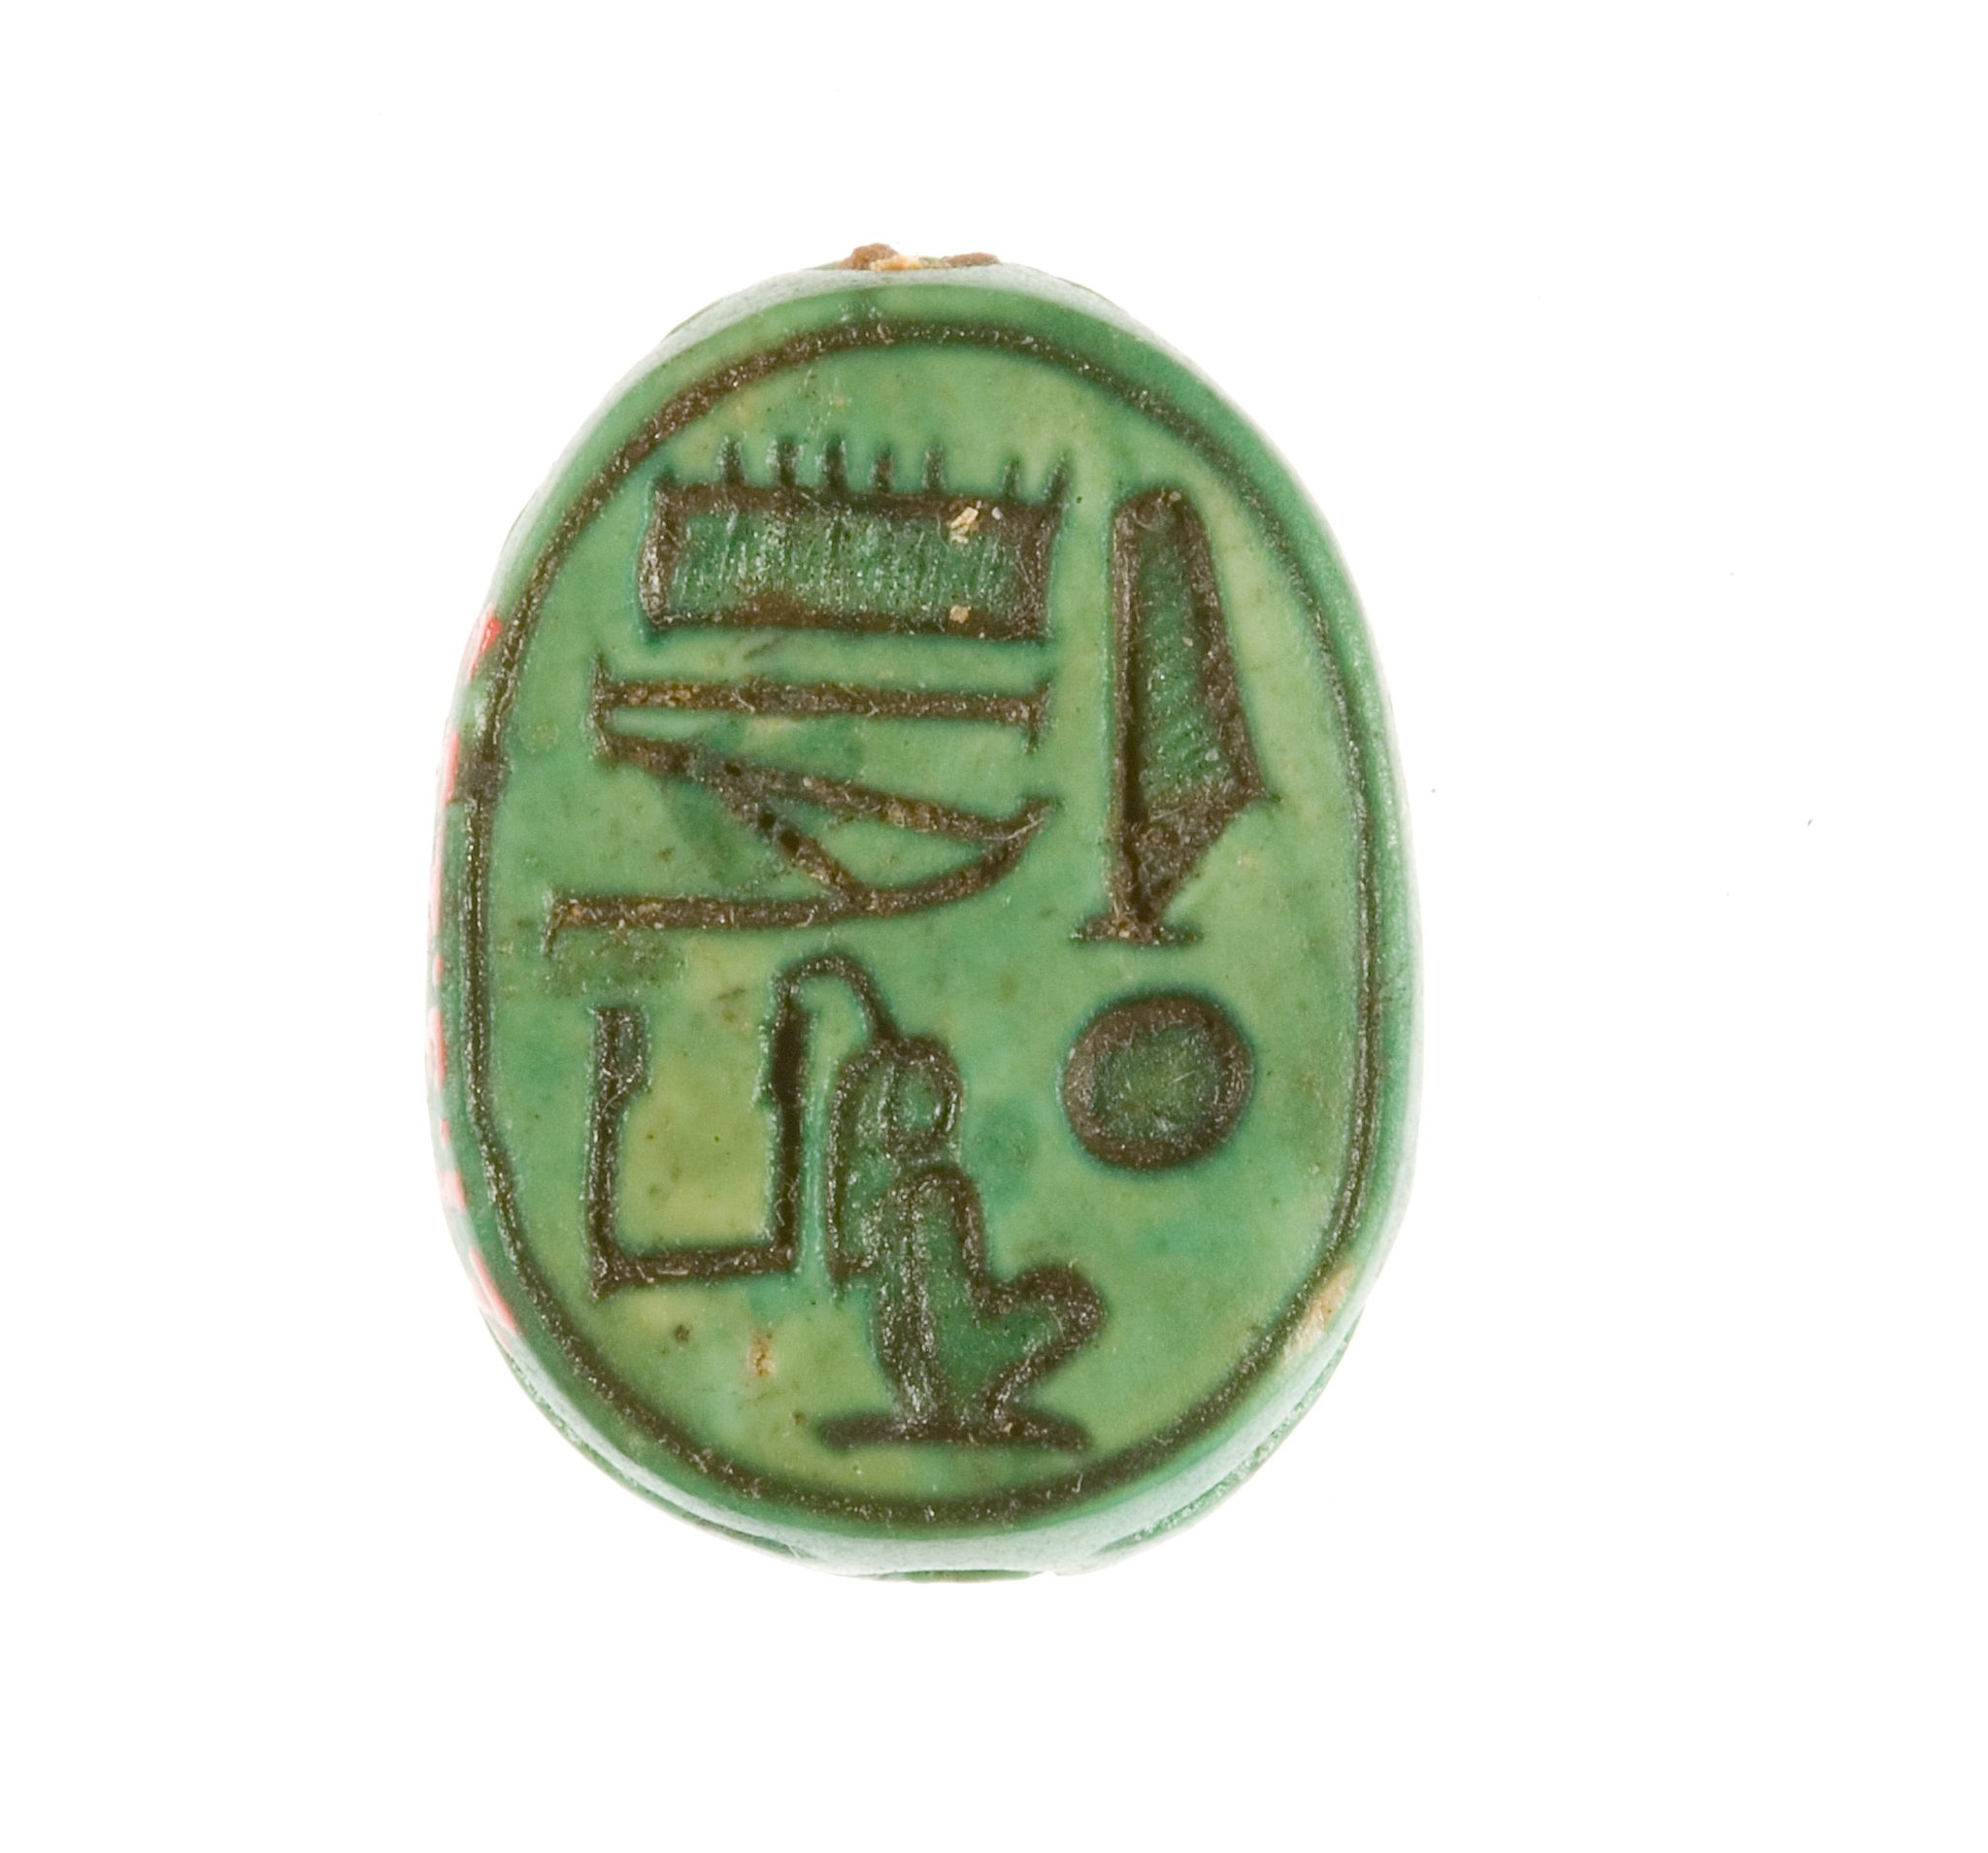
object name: scarab, maatkare, amun, simple back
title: Scarab for Maatkare (Hatshepsut), Beloved of Amun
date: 1479-1458 BCE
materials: stone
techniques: glazing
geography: egypt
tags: hieroglyphs,scarabs